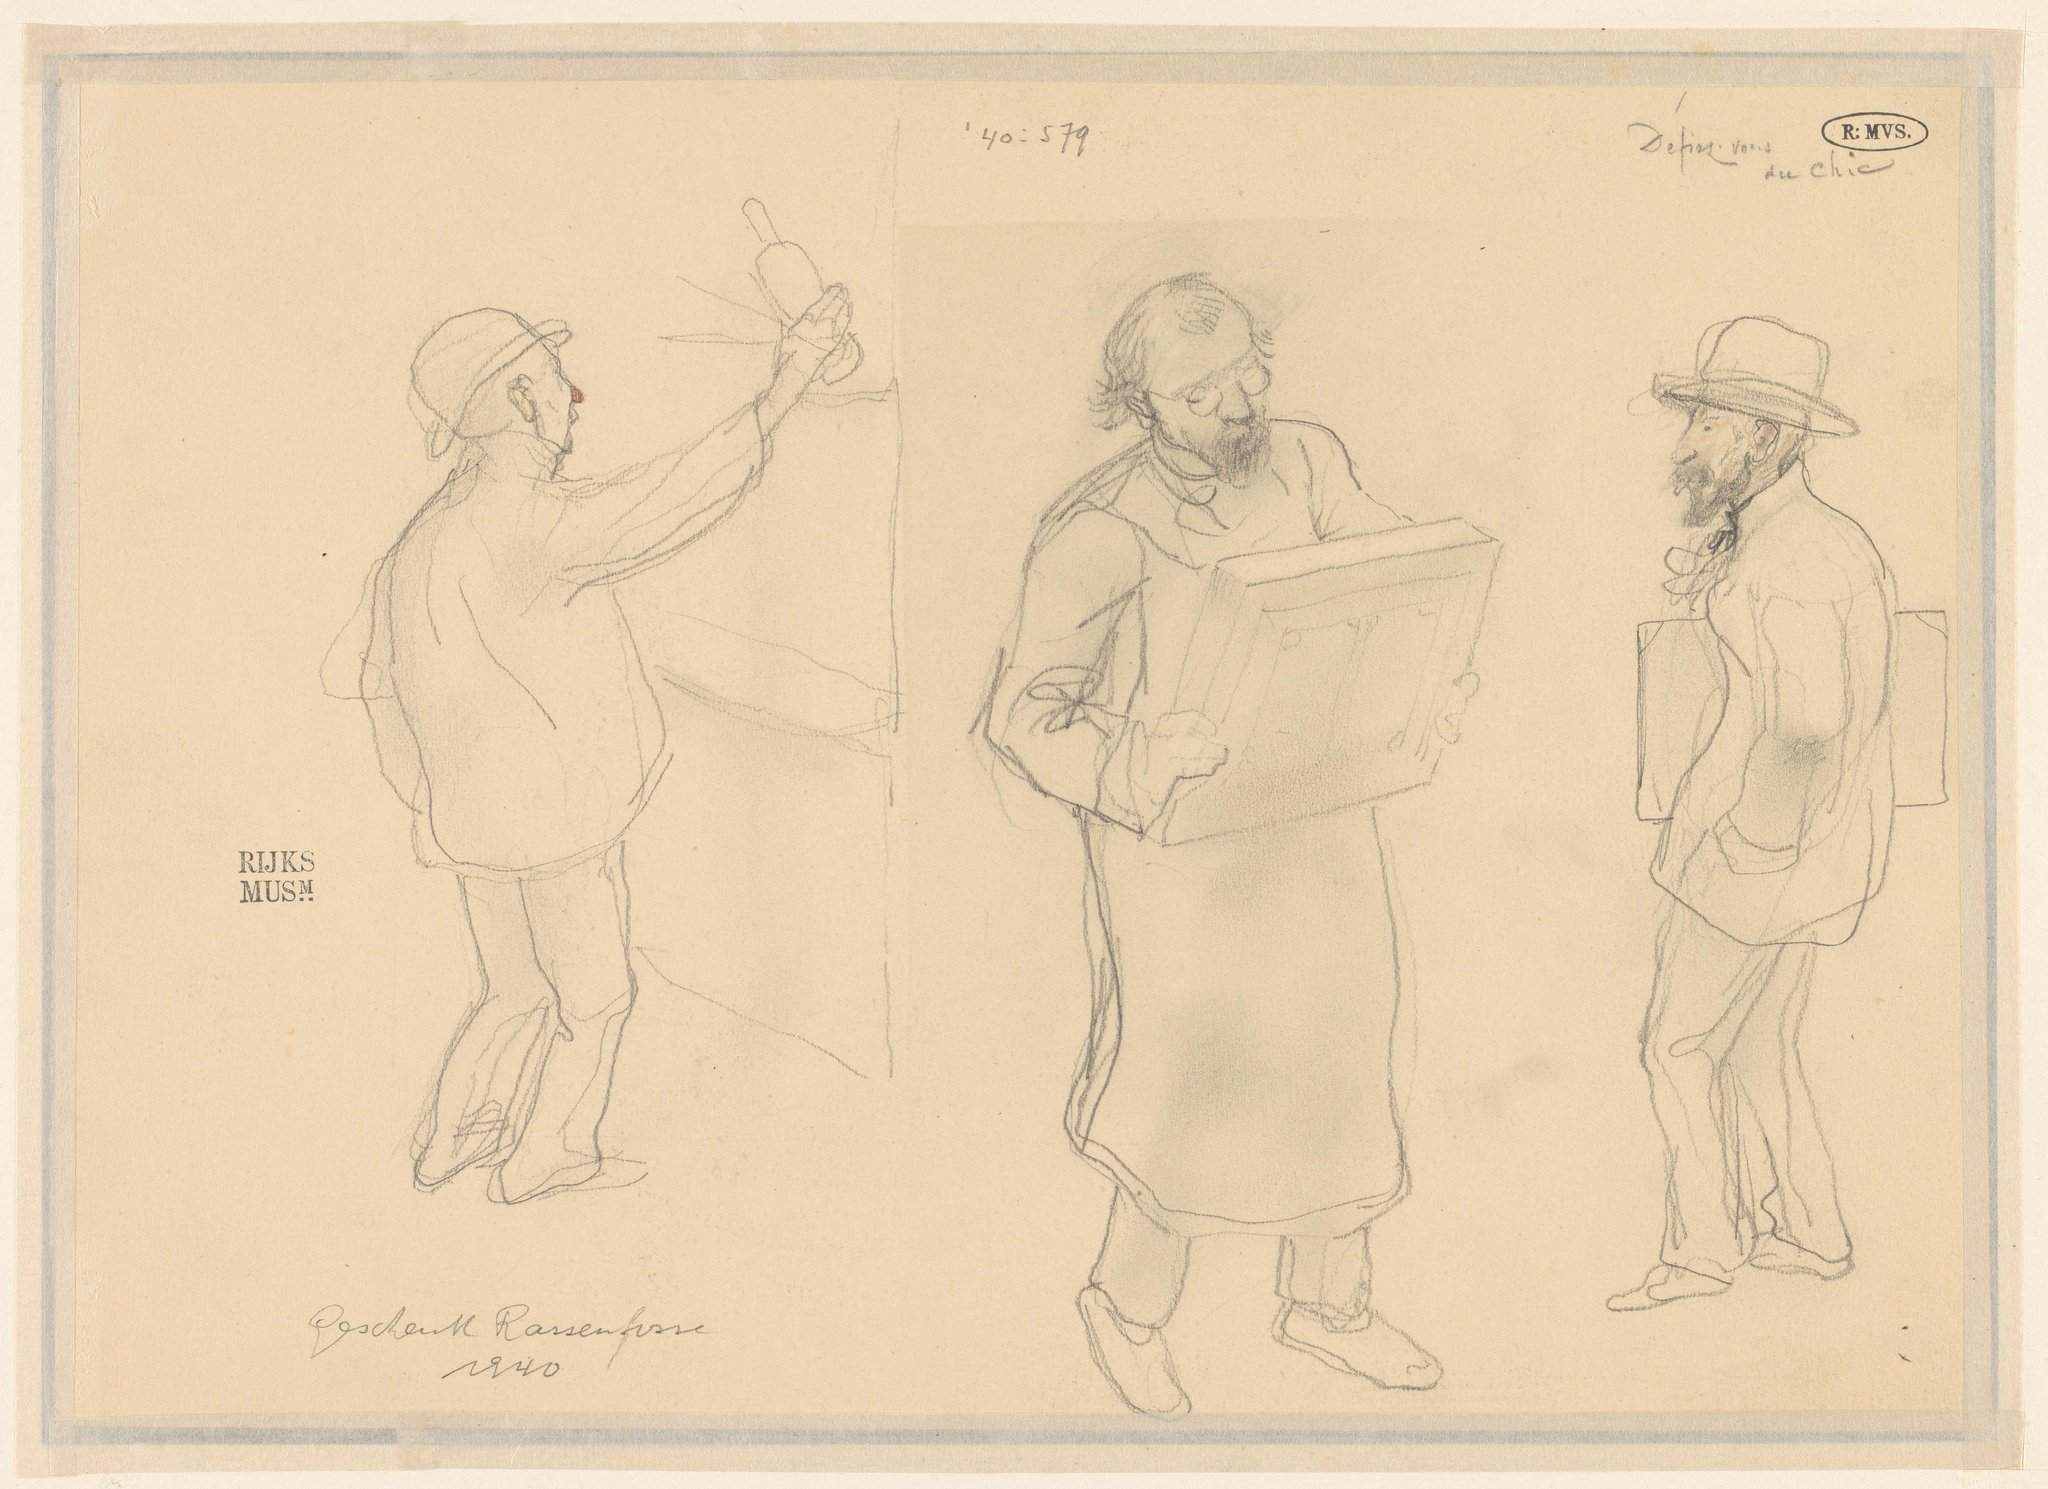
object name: drawing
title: Drie schetsen van mannen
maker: armand rassenfosse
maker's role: draughtsman, painter, print maker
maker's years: 1862-1934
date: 1872-1934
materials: paper, pencil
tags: standing figure